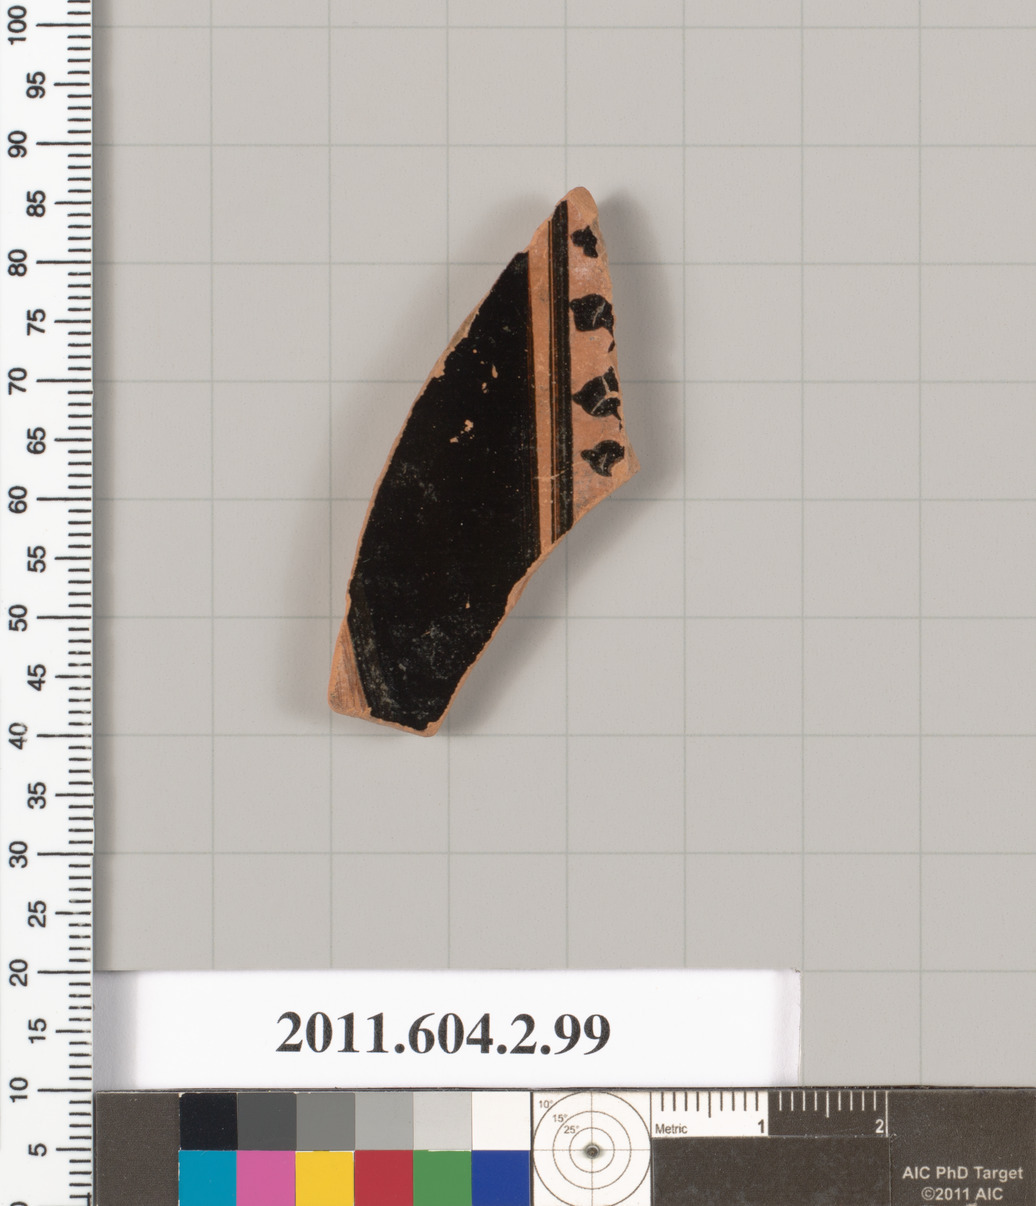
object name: pelike fragment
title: Terracotta fragment of a pelike (jar)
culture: greek, attic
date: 500-480 BCE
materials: terracotta